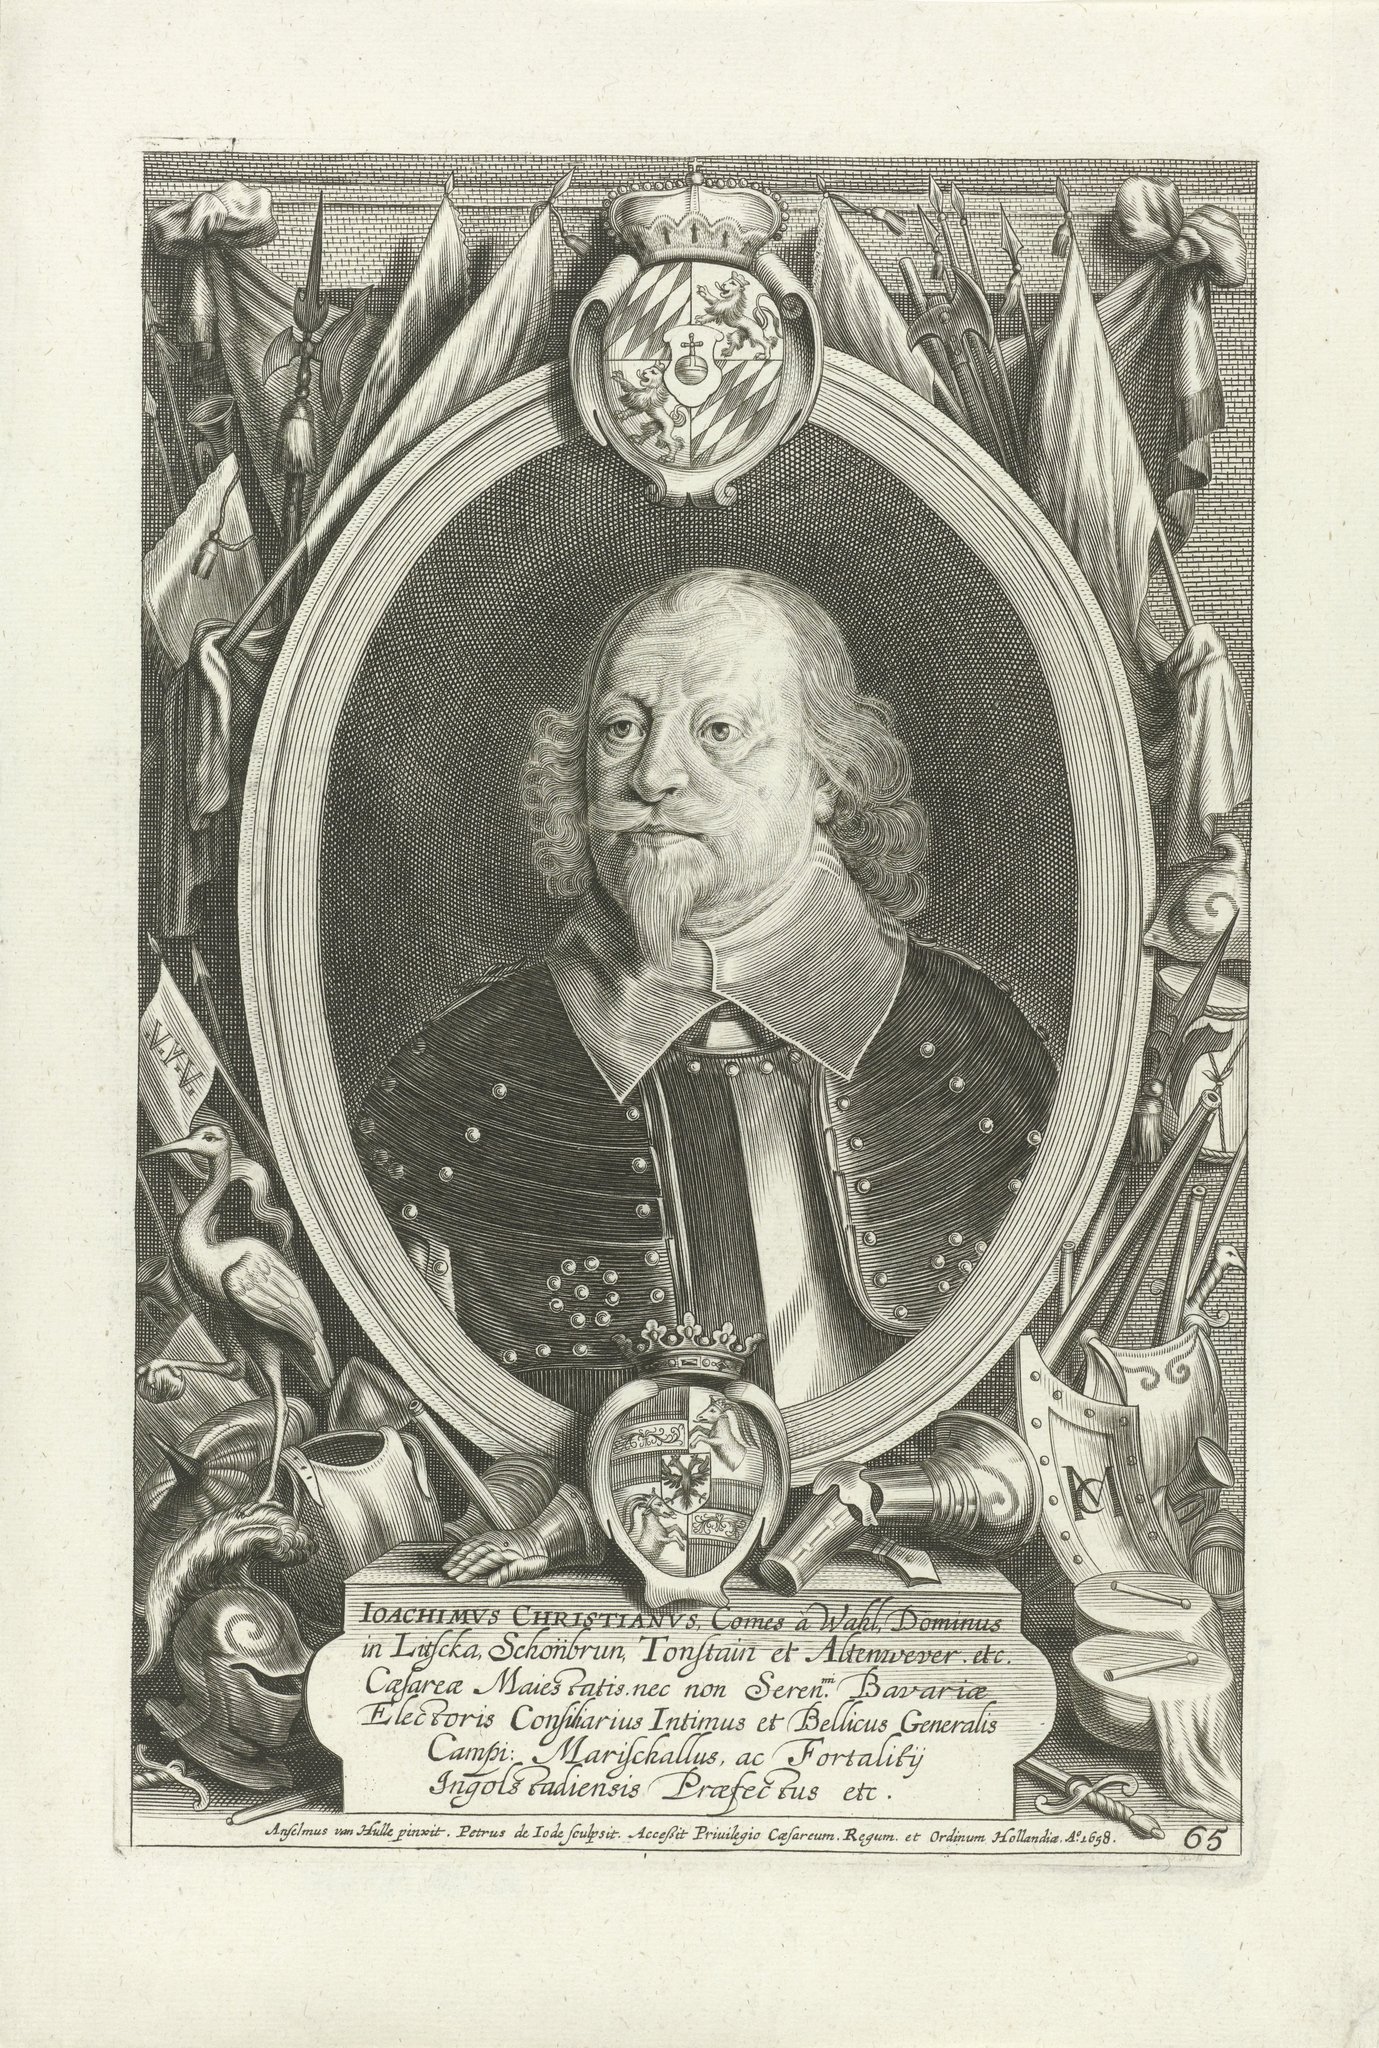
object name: print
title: Hommes illustres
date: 1658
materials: paper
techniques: engraving, etching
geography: antwerp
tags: shore-birds and wading-birds: heron, armour, weapons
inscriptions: collector's mark: Lugt 2228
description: Busteportret van Joachim Christian, graaf van Wahl, in harnas. Rechtsonder: 65. Het portret is gevat in een ovale omlijsting met het wapenschild van de geportretteerde. In het kader een zesregelig onderschrift in het Latijn. Rondom de omlijsting diverse wapens, vlaggen en een reiger. Prent uit een serie portretten naar schilderijen van Anselmus van Hulle van alle gedelegeerden bij de vredesonderhandelingen te Münster en Osnabrück.